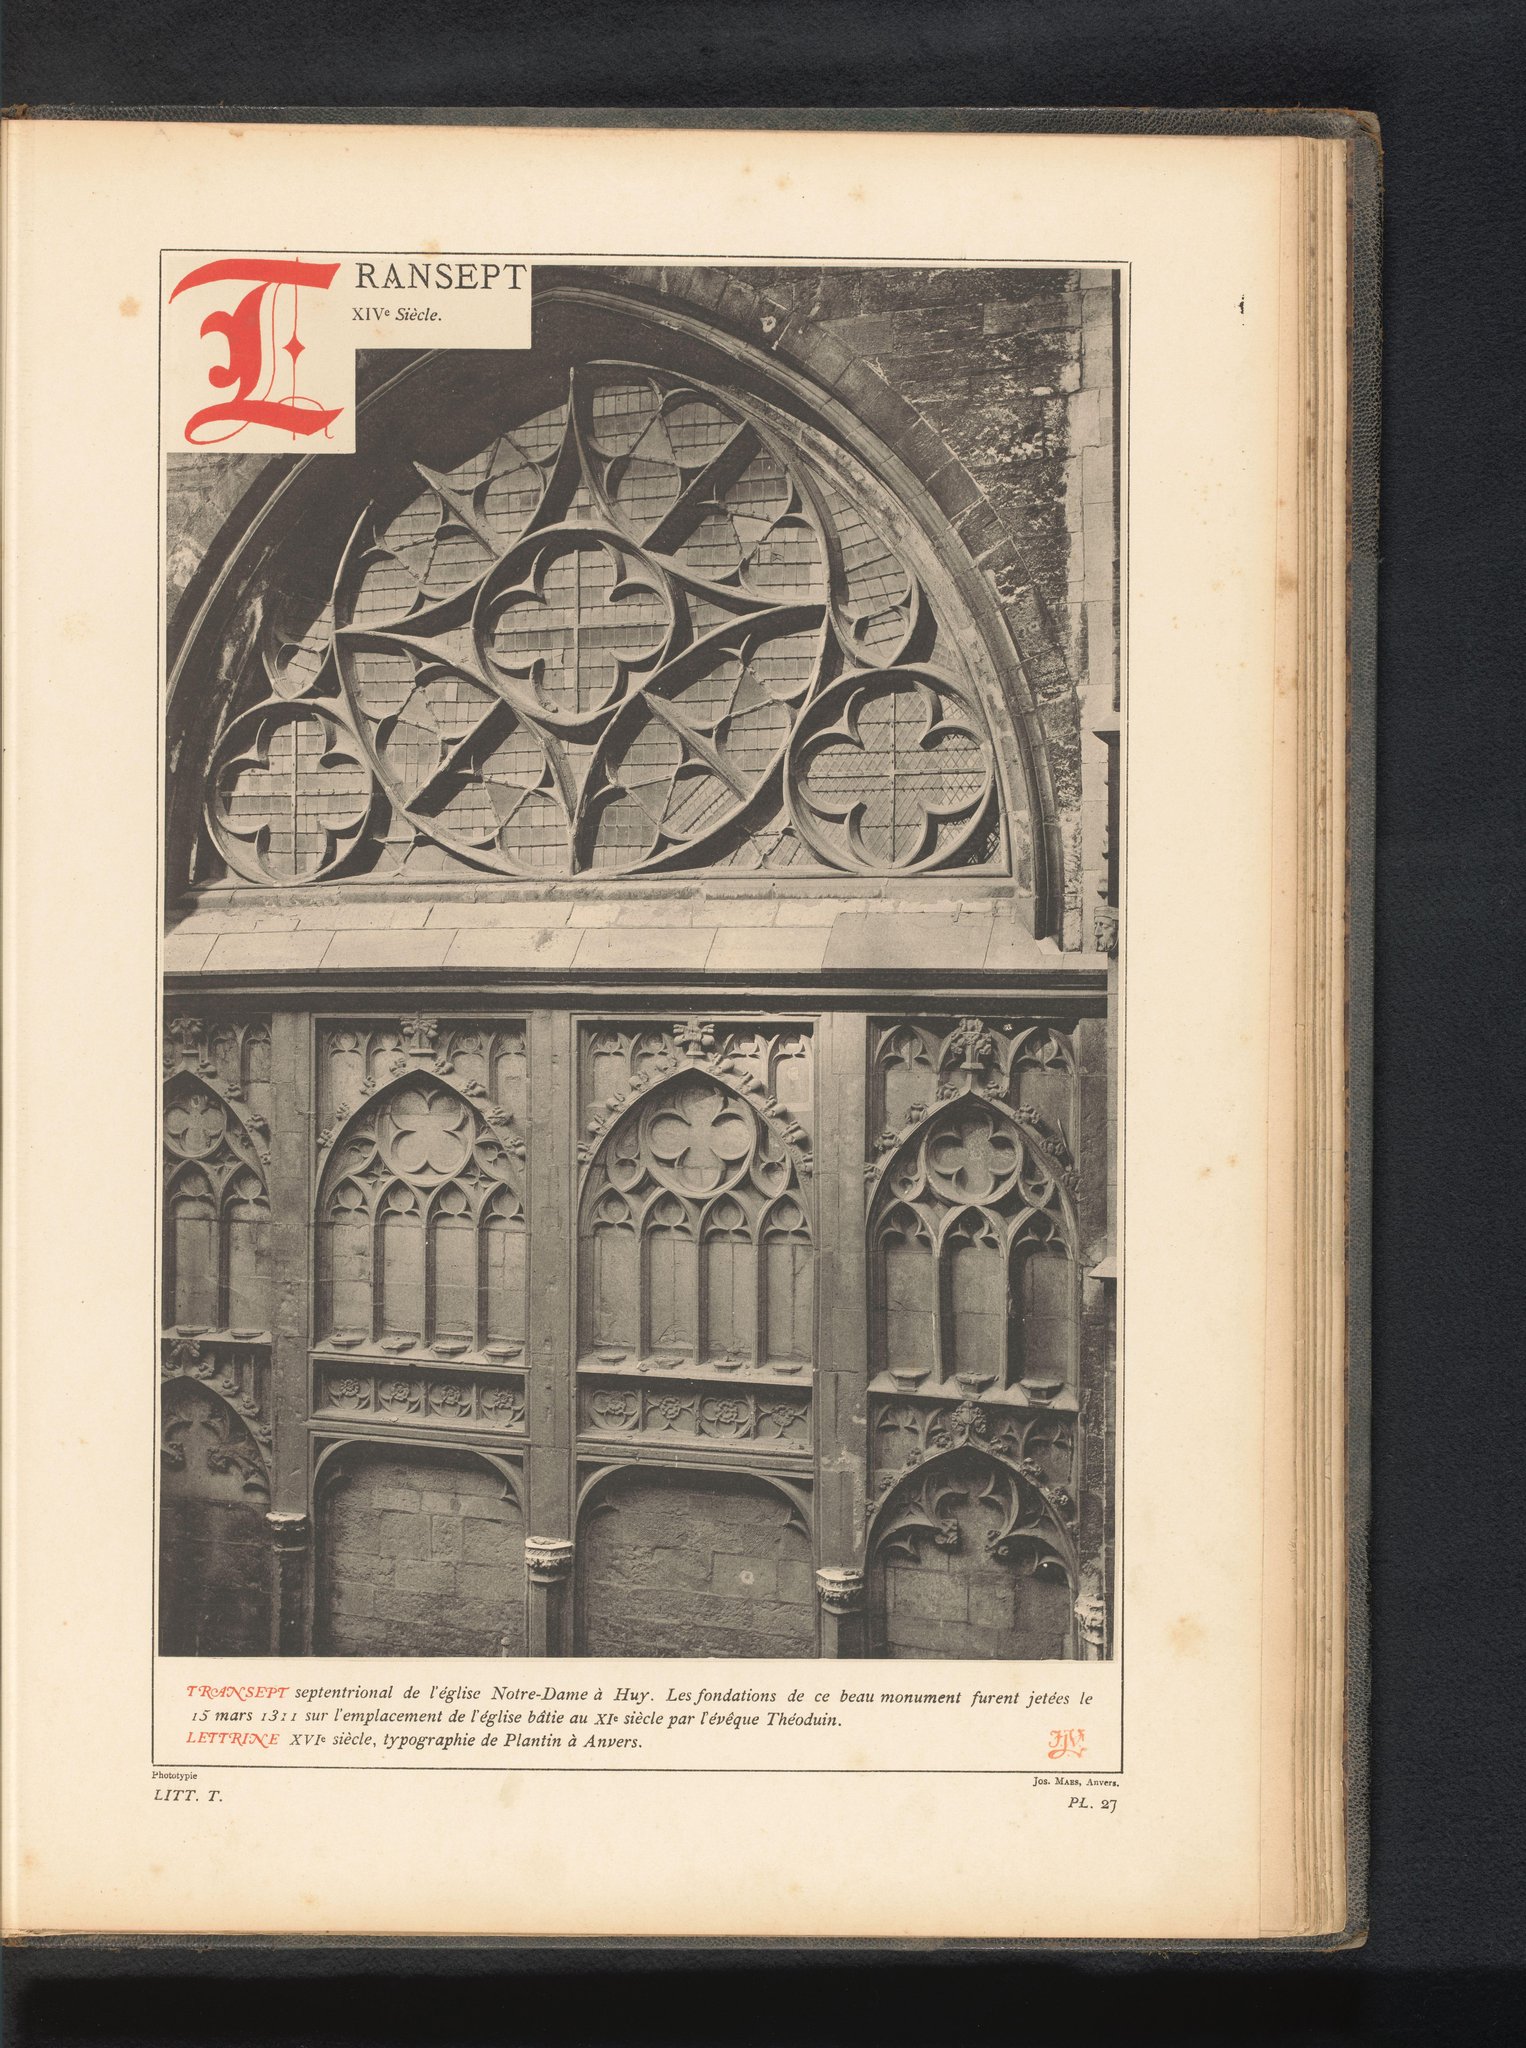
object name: photomechanical print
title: Transept van de Collegiale Onze-Lieve-Vrouw en Domitianus van Hoei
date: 1876-1881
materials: paper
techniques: photograph, photolithography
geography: antwerp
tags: parts of church exterior and annexes: transept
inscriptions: inscription: ‘LITT. T. - PL. 27.’, monogram: ‘JJvY’, inscription: ‘TRANSEPT septentrional de (...)’